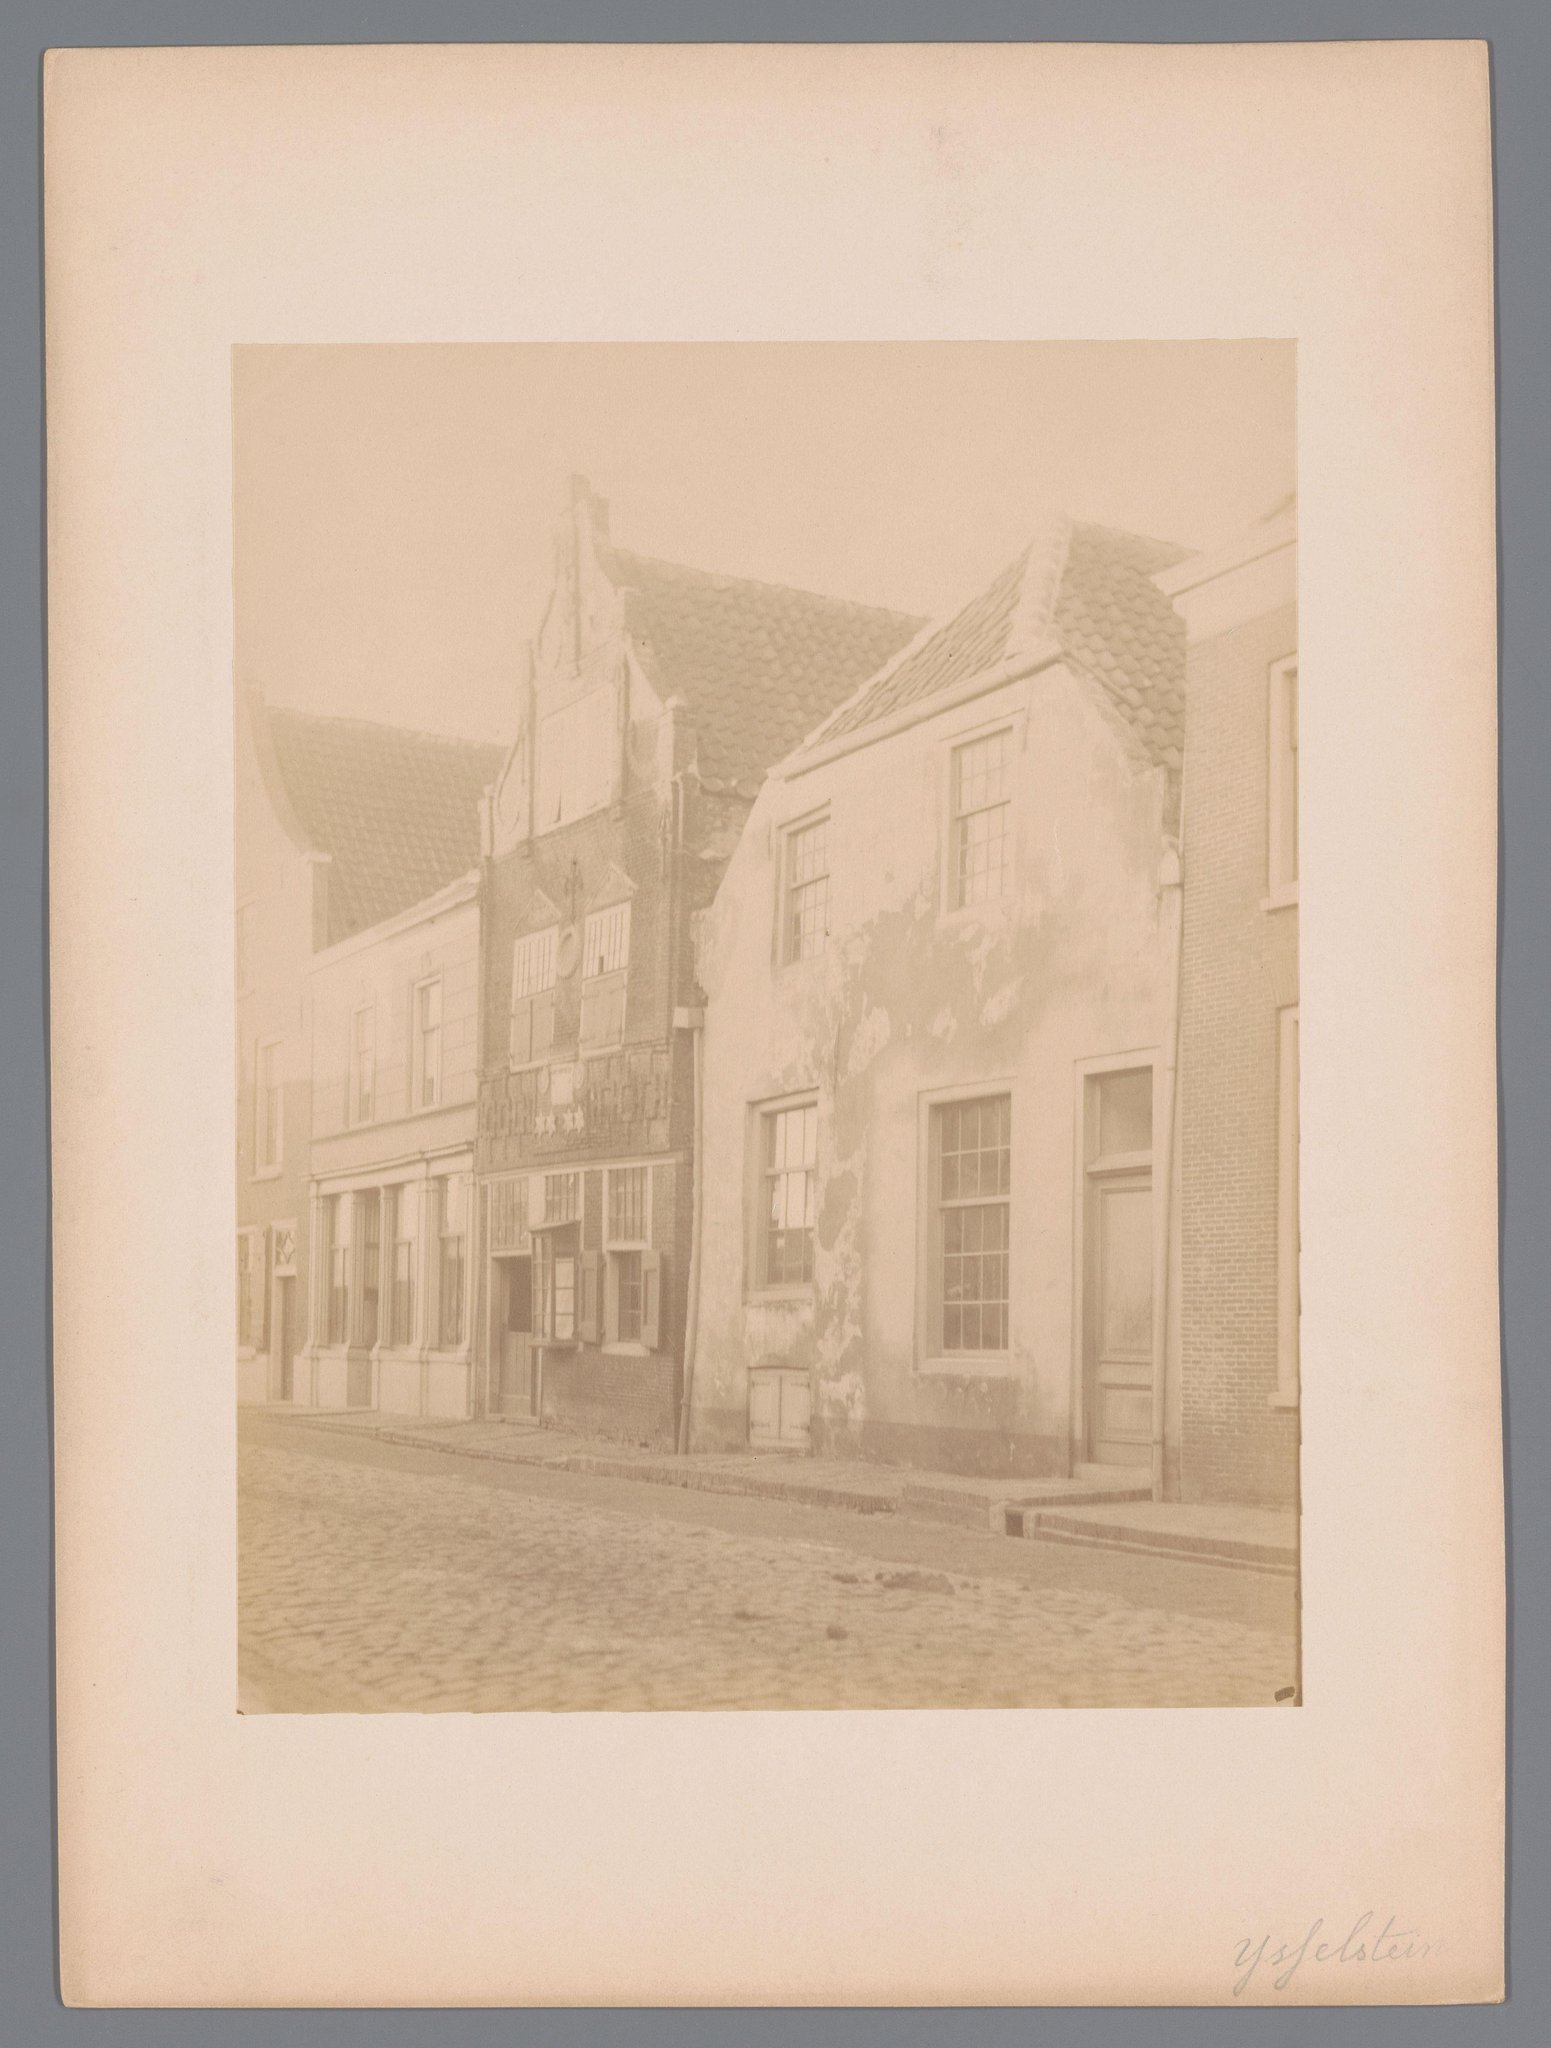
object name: photograph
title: Woningen in de Benschopperstraat te IJsselstein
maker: anoniem (monumentenzorg)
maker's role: fotograaf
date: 1889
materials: cardboard, photographic support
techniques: albumen print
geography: ijsselstein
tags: urban housing, street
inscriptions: annotation: ‘Woonhuis Benschopperstraat te IJsselstein afgebroken 1889’, annotation: ‘IJsselstein’